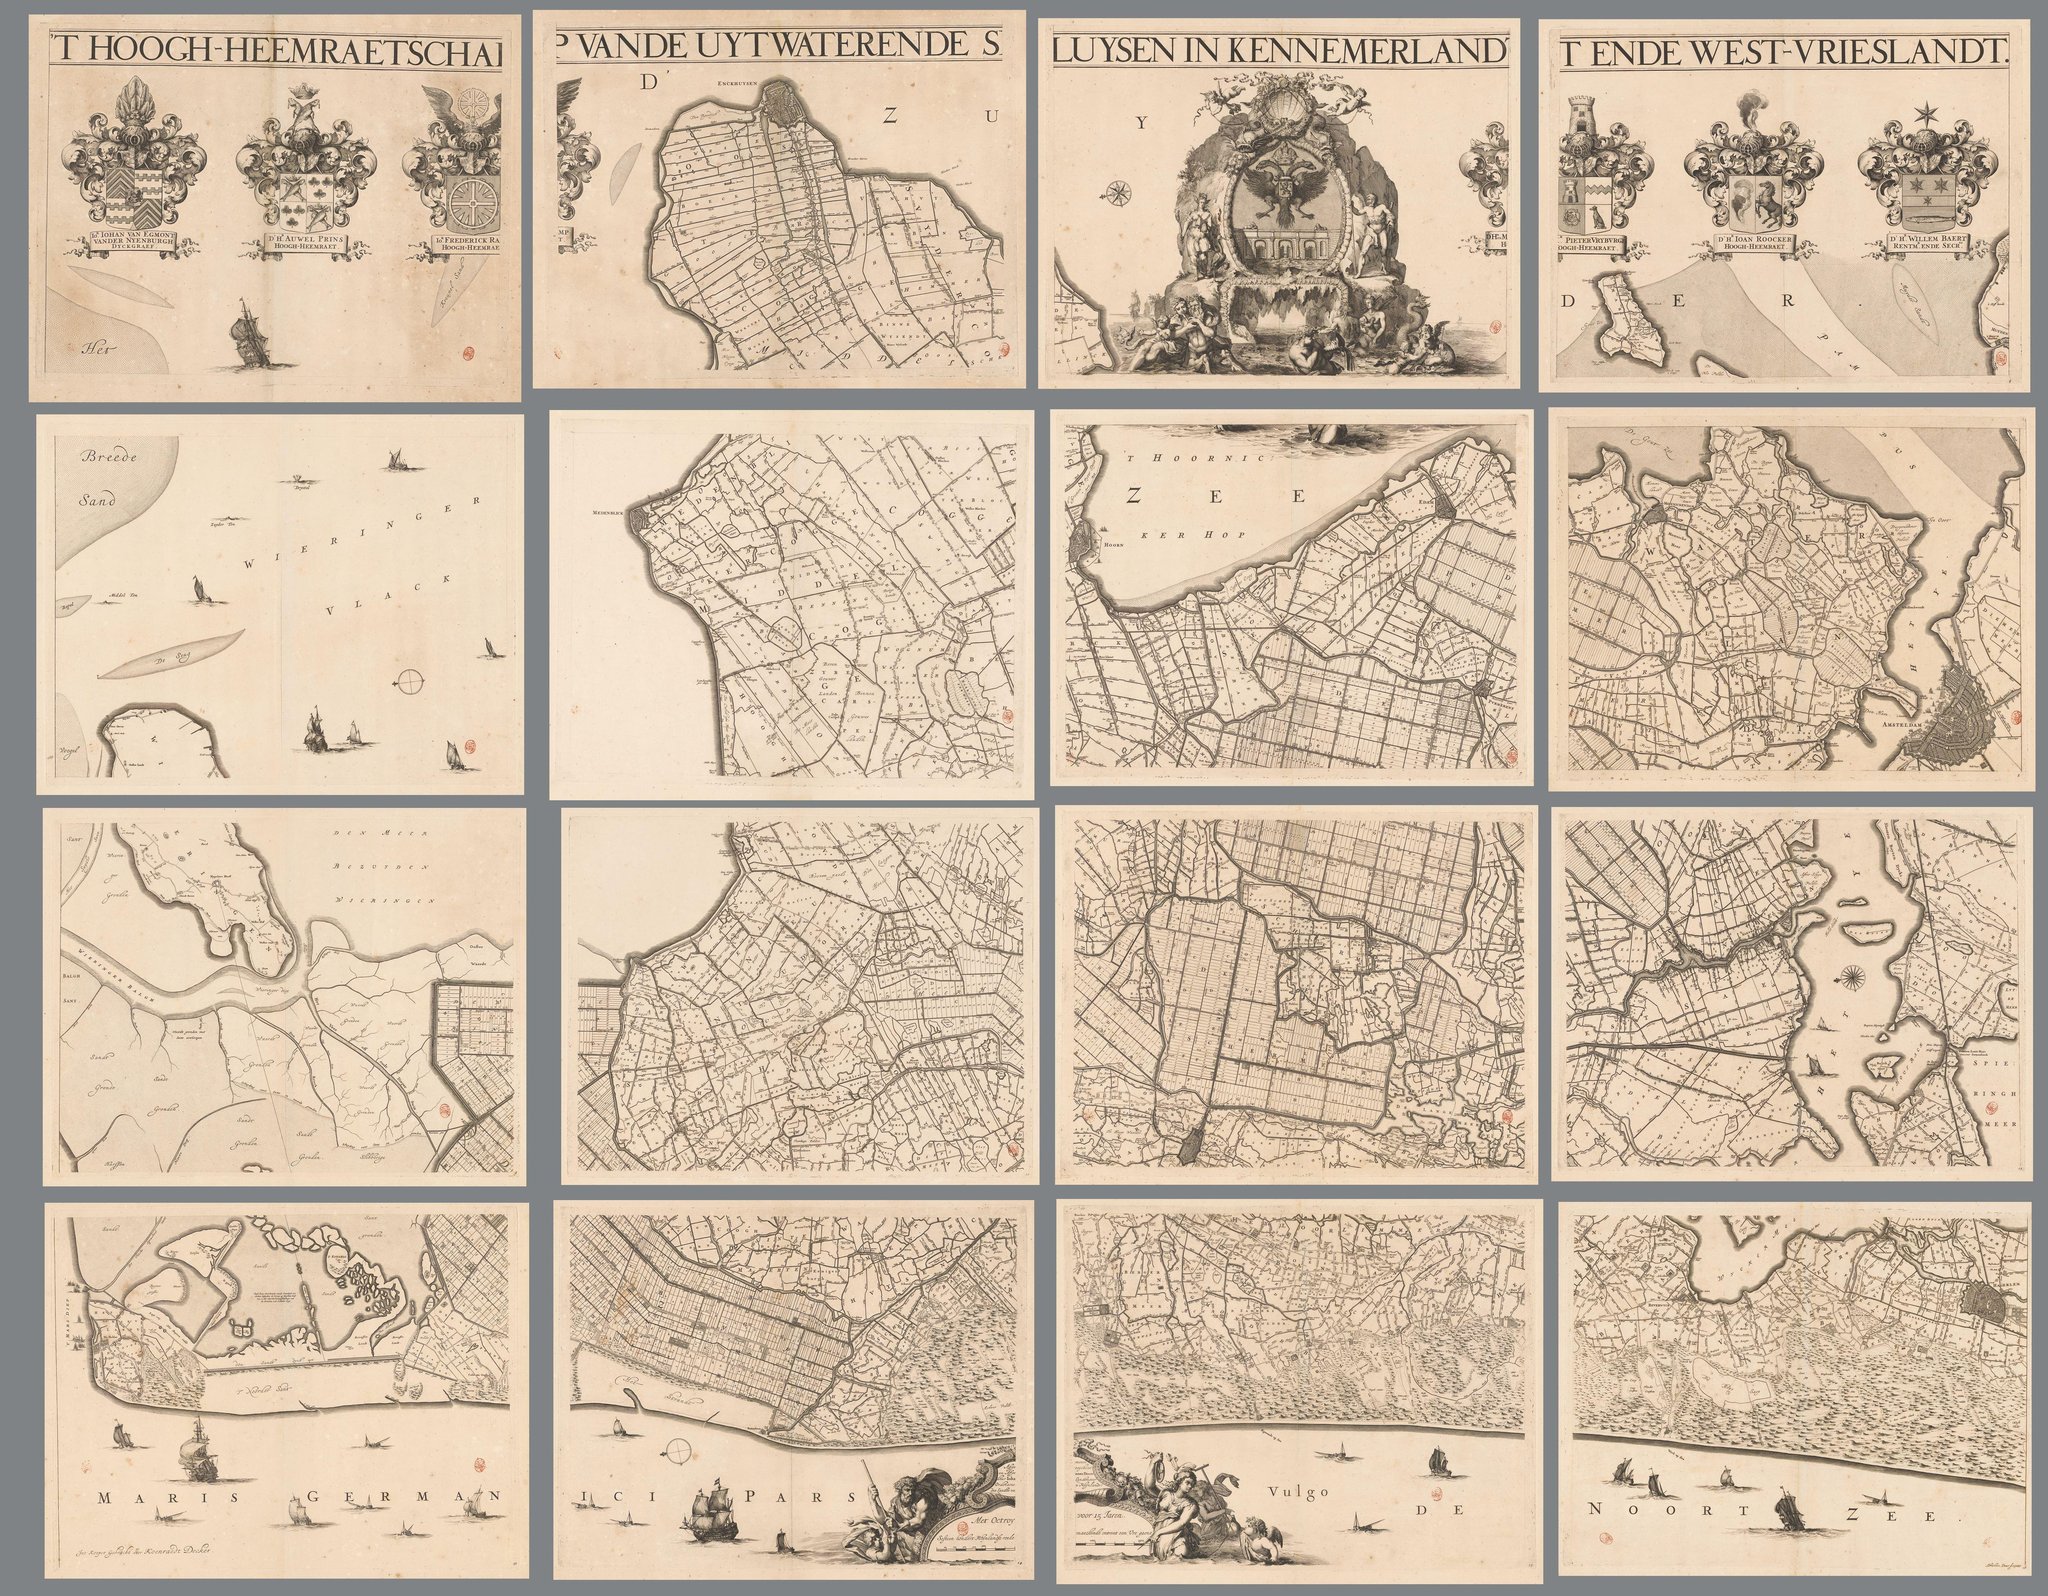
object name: map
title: Kaart van Kennemerland en West-Friesland, bestaande uit zestien delen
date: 1680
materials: paper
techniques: engraving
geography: amsterdam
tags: shore-birds and wading-birds: crane, (story of) neptune (poseidon), coat of arms (as symbol of the state, etc.), triton(s), maps of separate countries or regions, merman - aa - mermaid, siren, river-gods, instruments used in geodesy, surveying instruments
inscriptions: collector's mark: Lugt 195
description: Langs de bovenkant de titel. Linksboven de familiewapens van de dijkgraaf en twee hoogheemraden. Boven in het midden het wapen van het Hoogheemraadschap van de Uitwaterende Sluizen in Kennemerland en West-Friesland. Links daarvan een vrouwfiguur met twee vleugels en een sluis op haar hoofd, een staf met een oog in haar ene hand, een molen in haar andere hand en een kraanvogel met een steen in zijn ene poot naast zich. Zij en de vogel staan waarschijnlijk symbool voor de waakzaamheid van het hoogheemraadschap. Rechts van het wapen Neptunus. Onder het wapen in de zee een riviergod, een zeemeermin met kind, een triton, putti en nog een aantal zeewezens. Rechtsboven de familiewapens van twee hoogheemraden en de rentmeester. Onderaan in het midden een schaalstok: Sestien hondert Rhynlandse roede maeckende ontrent een ure gaens. Rechts daarvan een riviergod en een putto. Links van de schaalstok een vrouwfiguur met meetapparatuur in haar handen, naast haar een putto en achter haar nog een vrouwfiguur. Oriëntatie: noorden links.